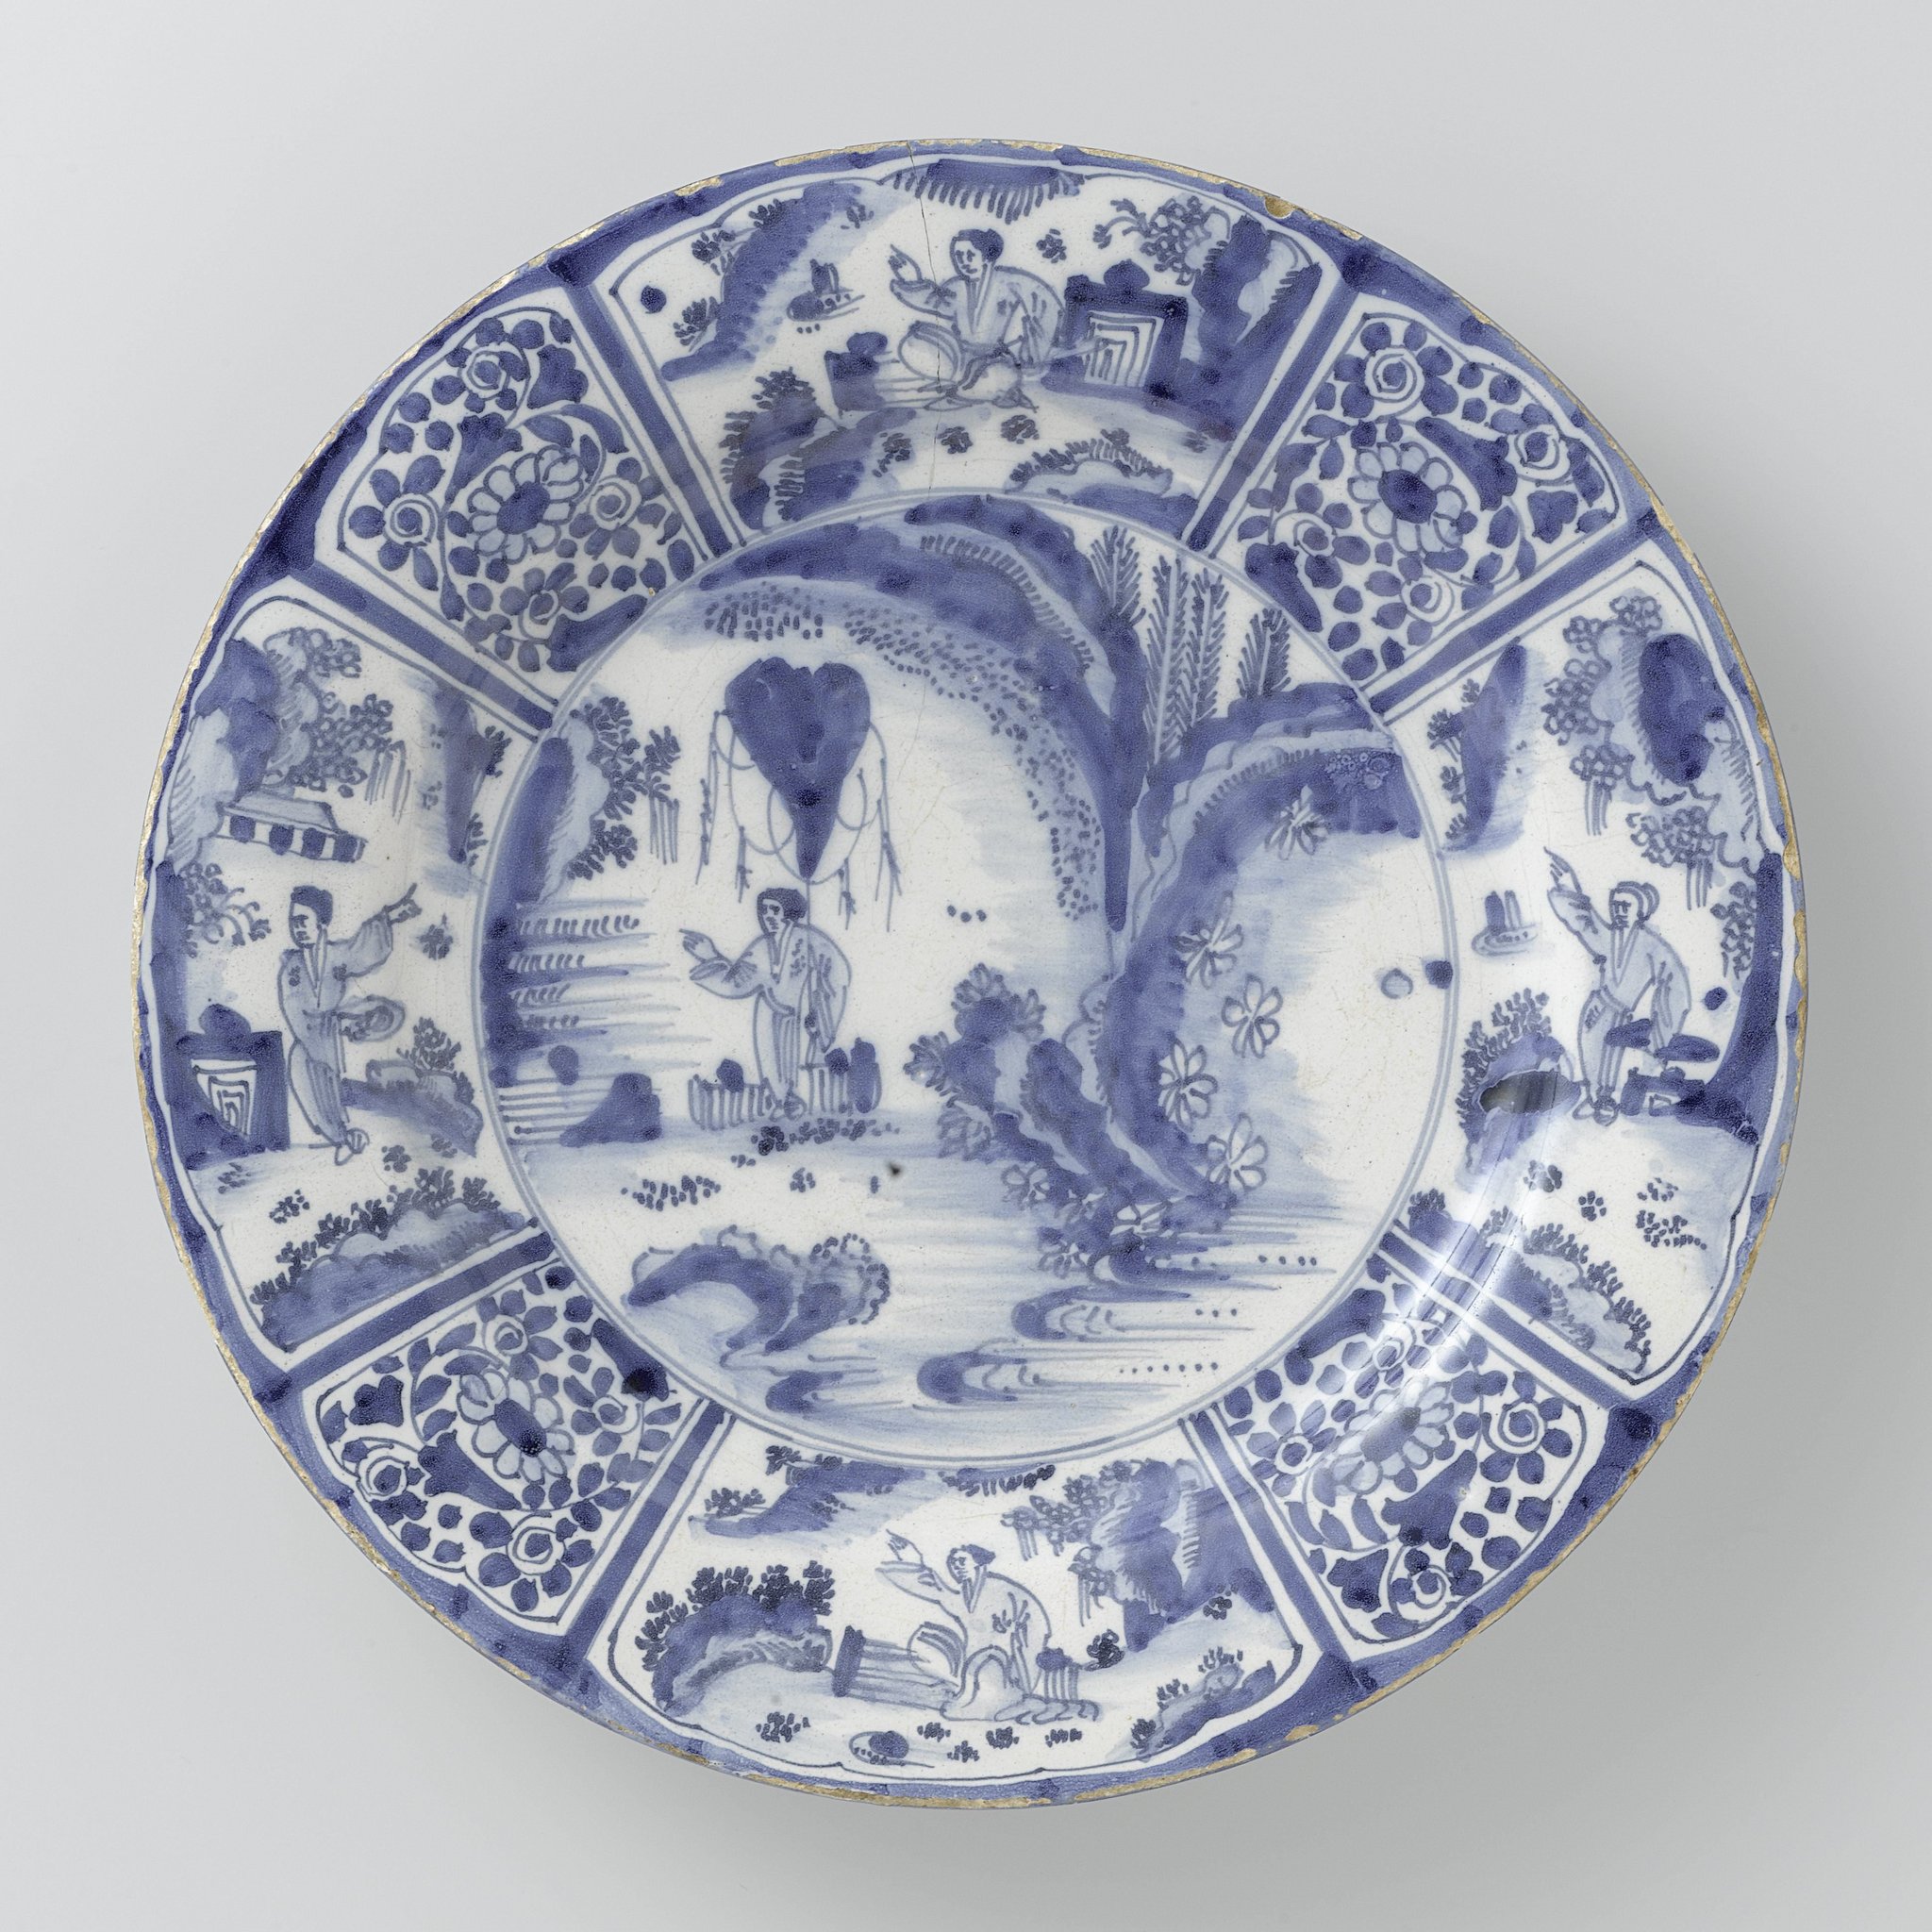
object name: platter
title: Schotel, op het plat in blauw beschilderd met een Chinees die een baldakijn ophoudt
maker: Anonymous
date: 1650-1670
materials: earthenware, glaze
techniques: painted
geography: delft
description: Ronde schotel van blauw beschilderde faience. Op het plat is een landschap geschilderd met daarin een figuur (Chinees) die een baldakijn ophoudt. De rand is verdeeld in acht vakken. In twee grote vakken is een staande figuur in een landschap geschilderd, in twee andere grote vakken een zittende figuur in een landschap en in vier kleine vakken bloemenranken.